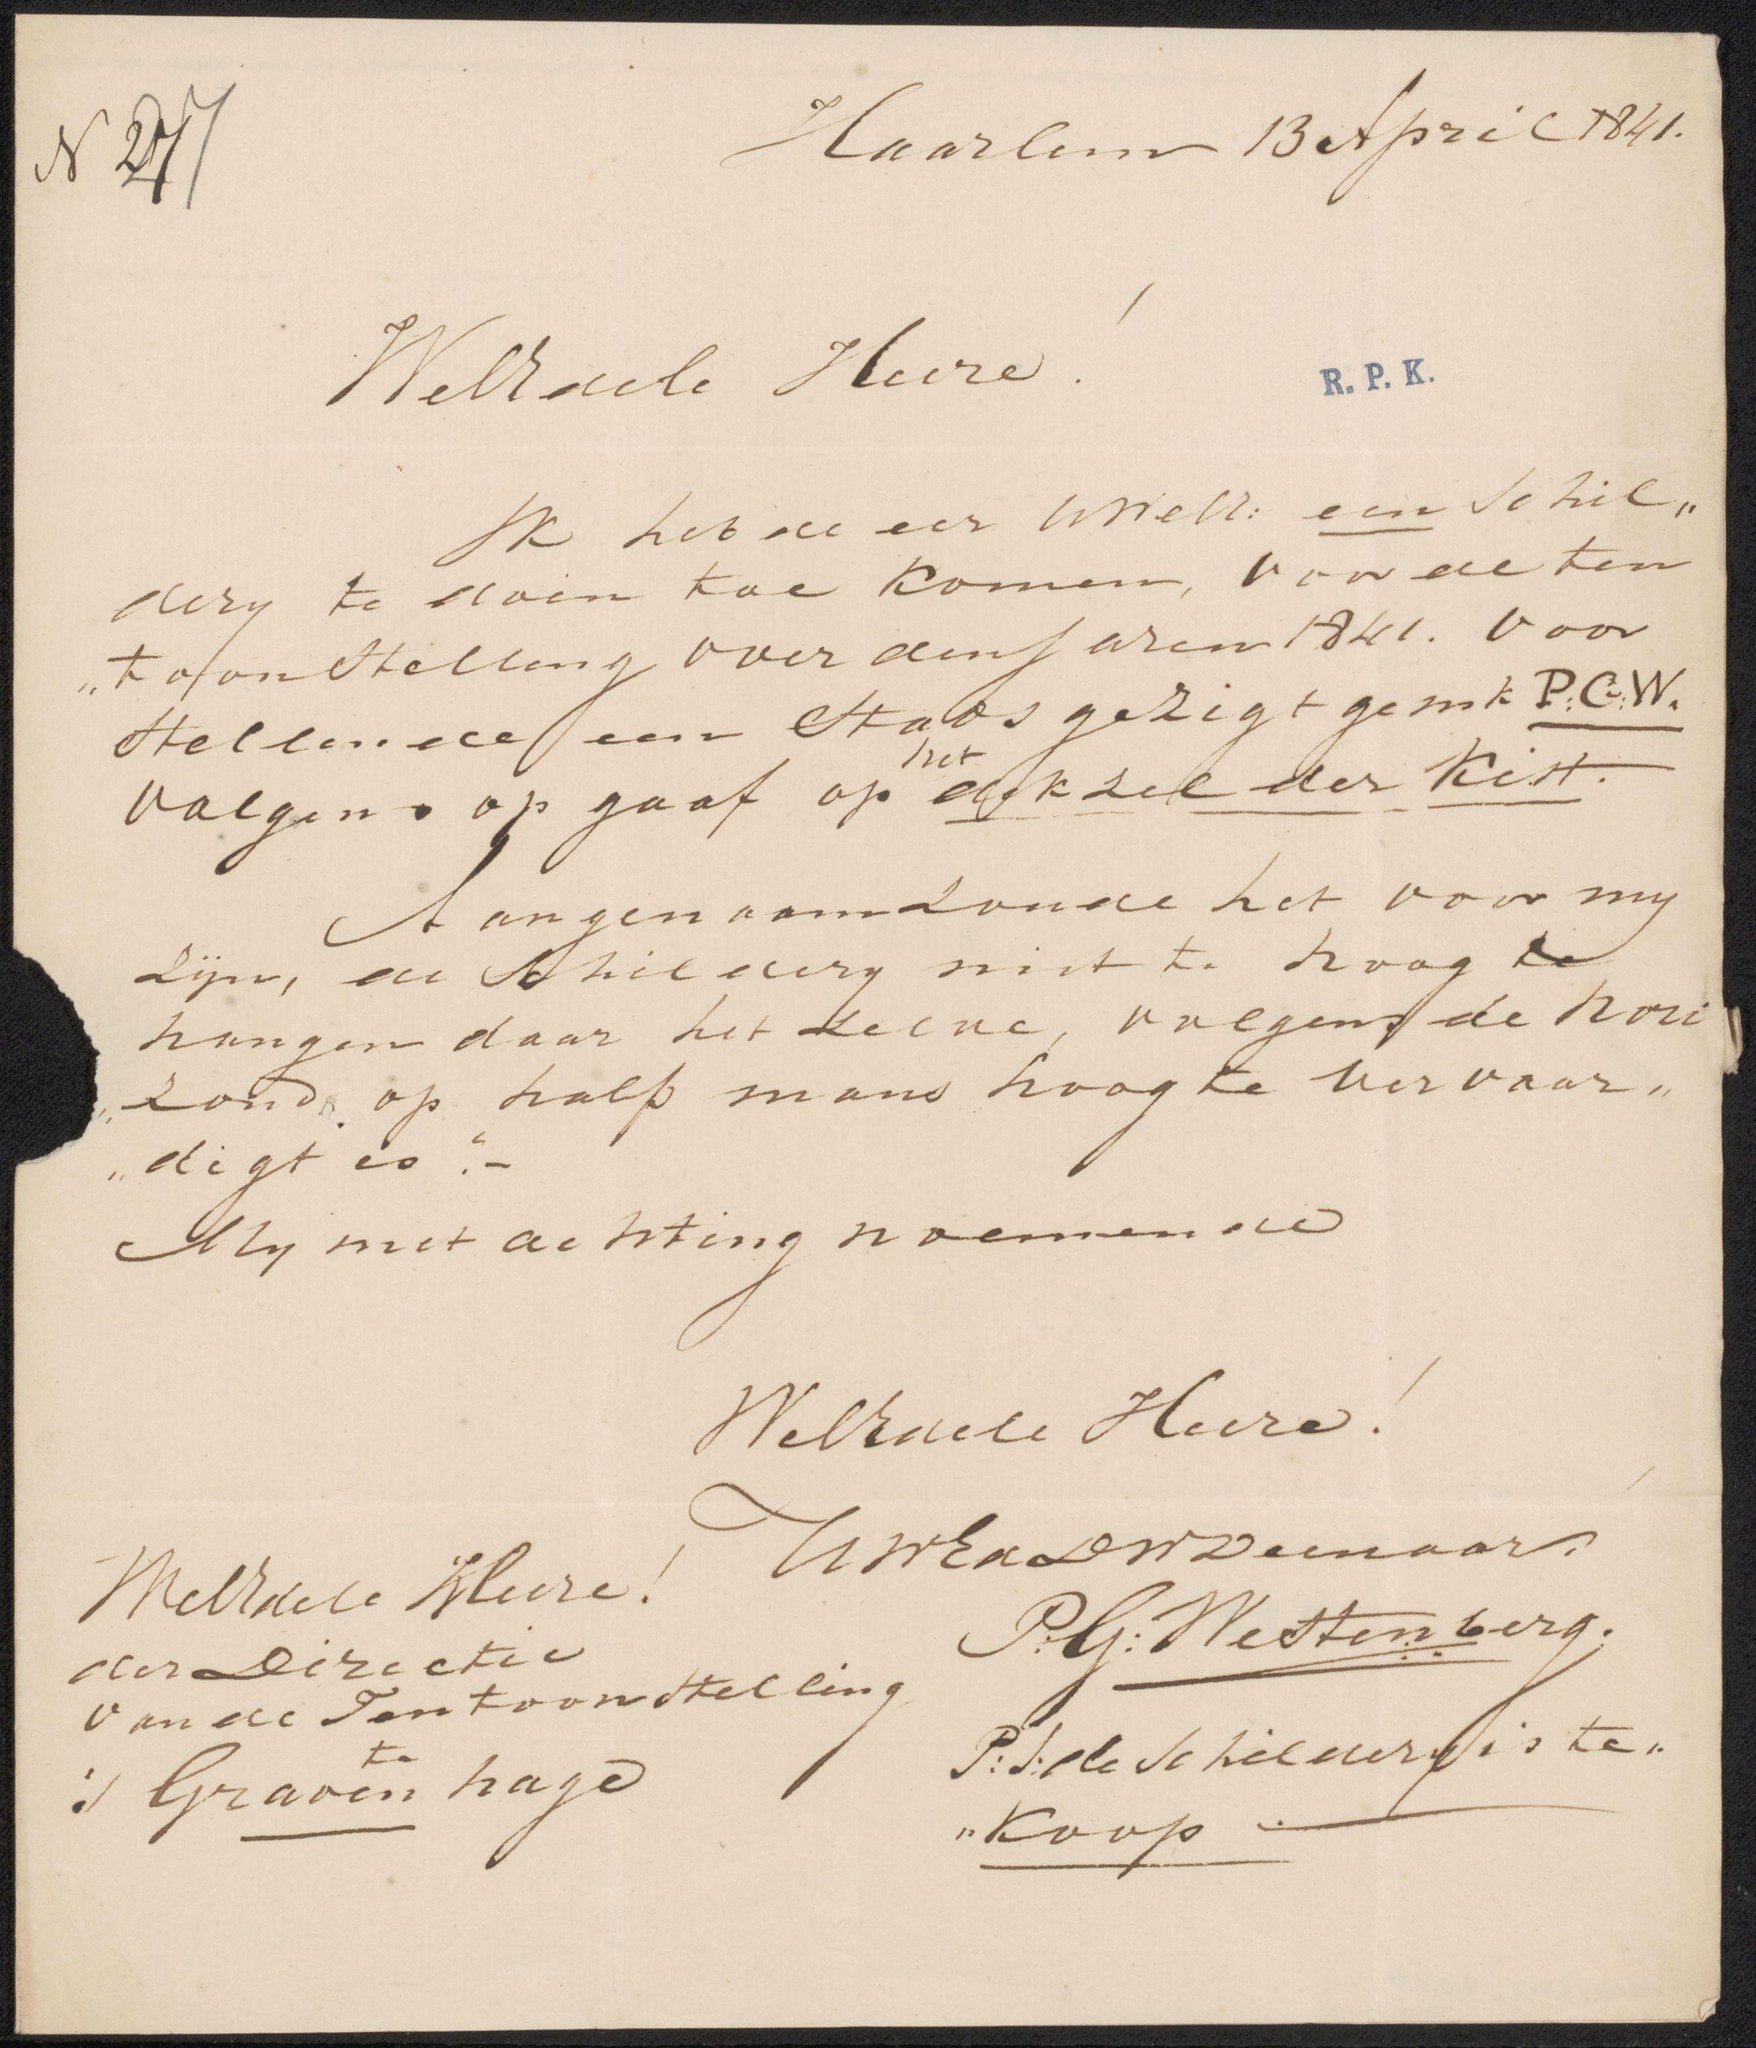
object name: letter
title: Brief aan G.M.C. Hooft, secretaris van de commissie van de Tentoonstelling van Levende Meesters in Den Haag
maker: george pieter westenberg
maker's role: draughtsman, painter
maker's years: 1791-1873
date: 1841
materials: ink, paper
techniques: pen, writing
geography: haarlem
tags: painting (including book-illumination, miniature-painting), exhibition ~ art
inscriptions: collector's mark: Lugt 2233, watermark